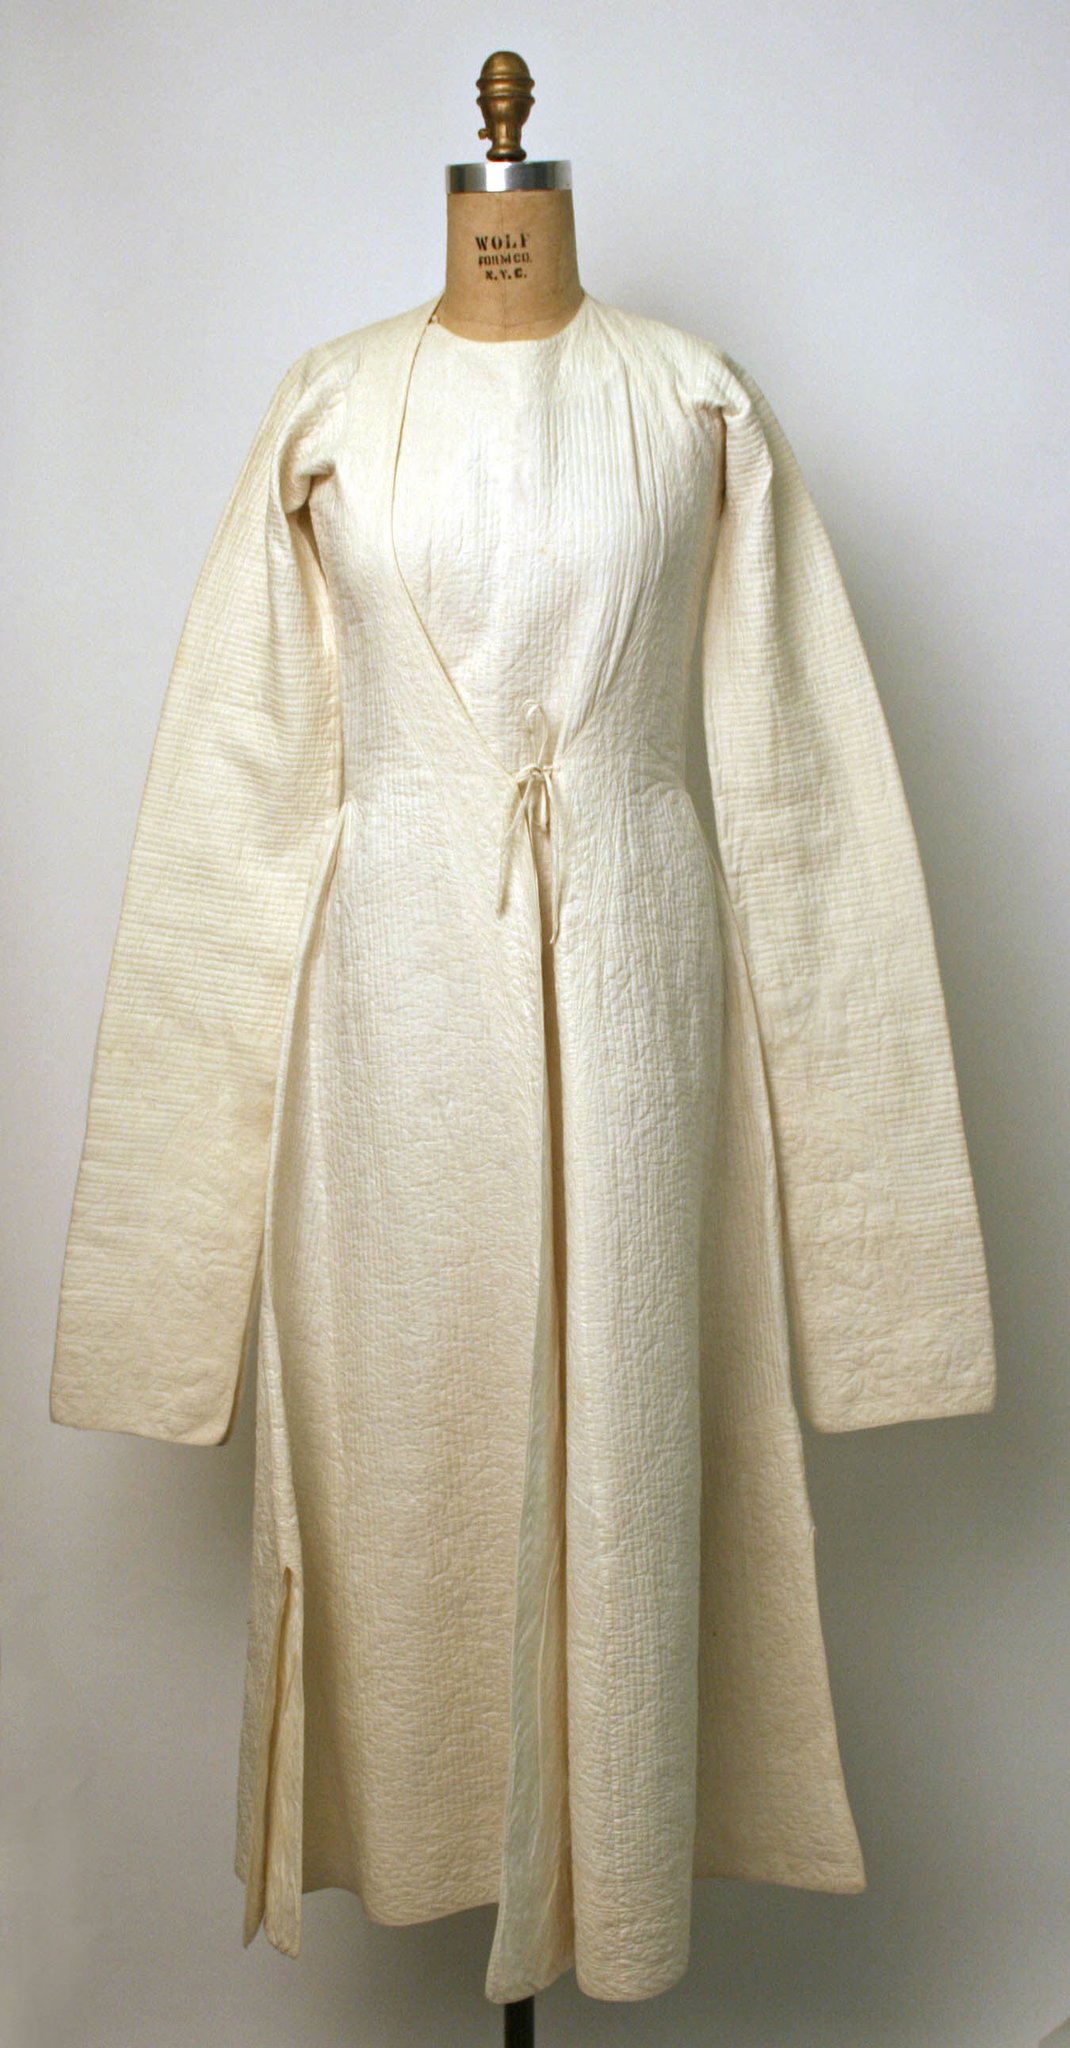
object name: coat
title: Angarkha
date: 1701-1800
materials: cotton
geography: india